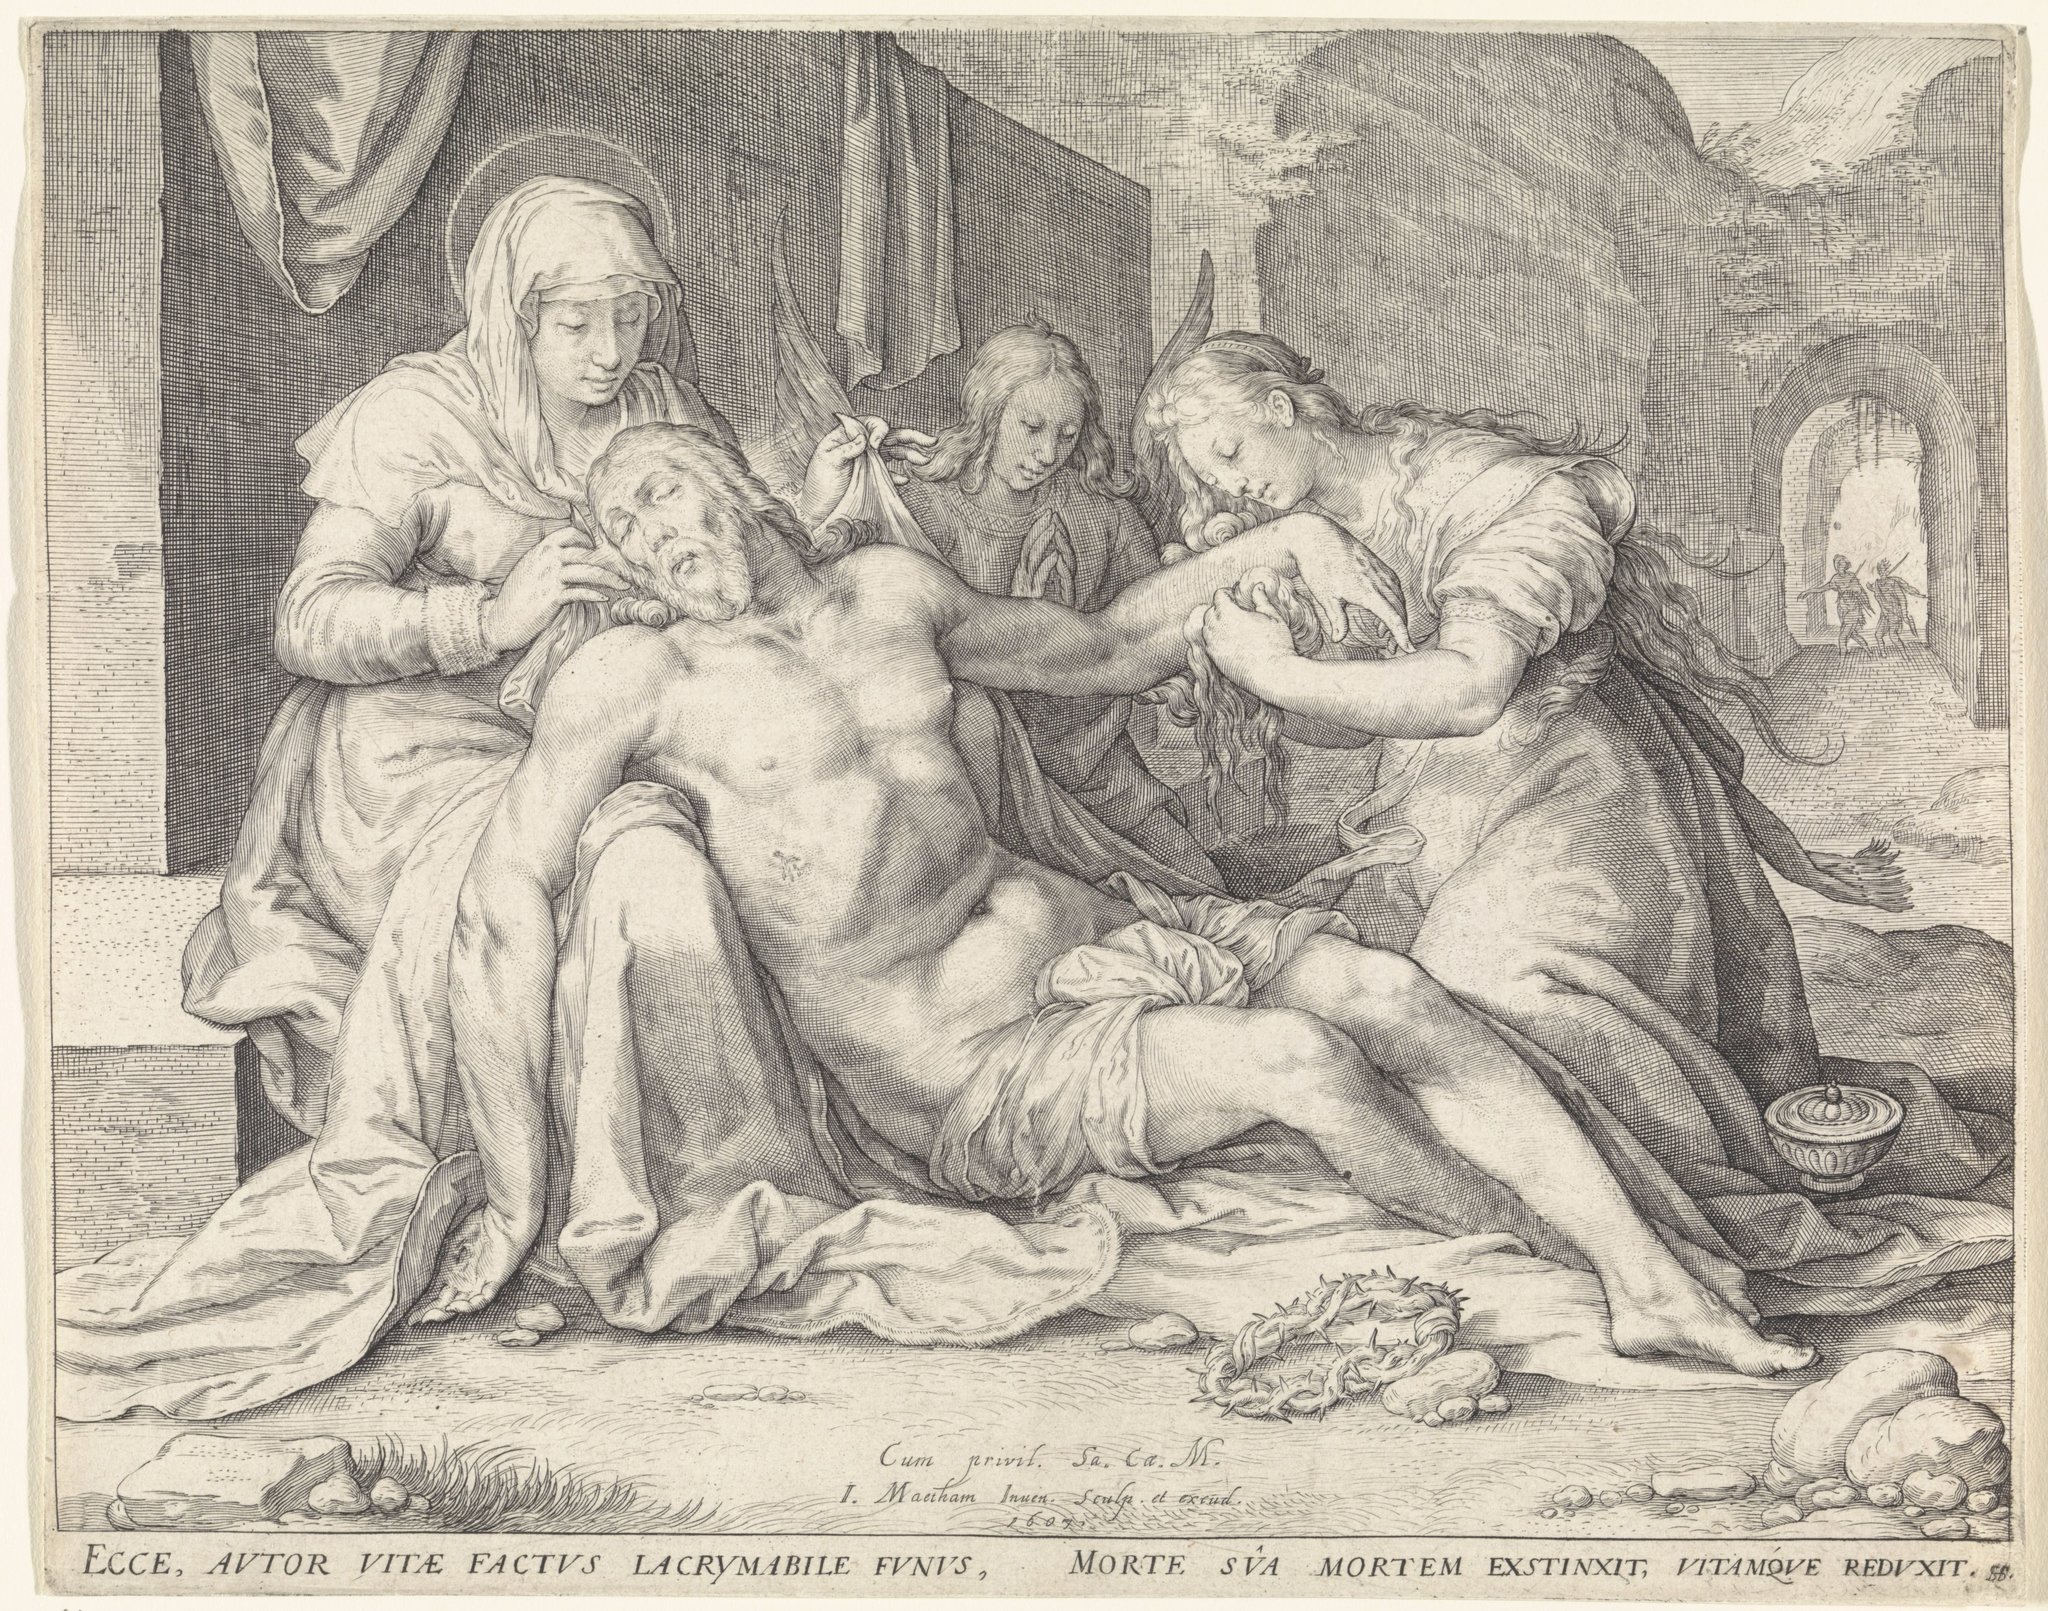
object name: print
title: Bewening van Christus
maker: jacob matham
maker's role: draughtsman, print maker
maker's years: 1571-1631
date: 1607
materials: paper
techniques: engraving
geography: haarlem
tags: the dead christ in mary's lap, the penitent harlot mary magdalene; possible attributes: book (or scroll), crown, crown of thorns, crucifix, jar of ointment, mirror, musical instrument, palm-branch, rosary, scourge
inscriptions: collector's mark: Lugt 240, date: ‘1607’, signature and address: ‘J. Matham Inven Sculp. et excud.’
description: Het lichaam van Christus op de schoot van Maria met links Maria Magdalena en achter hen een engel.